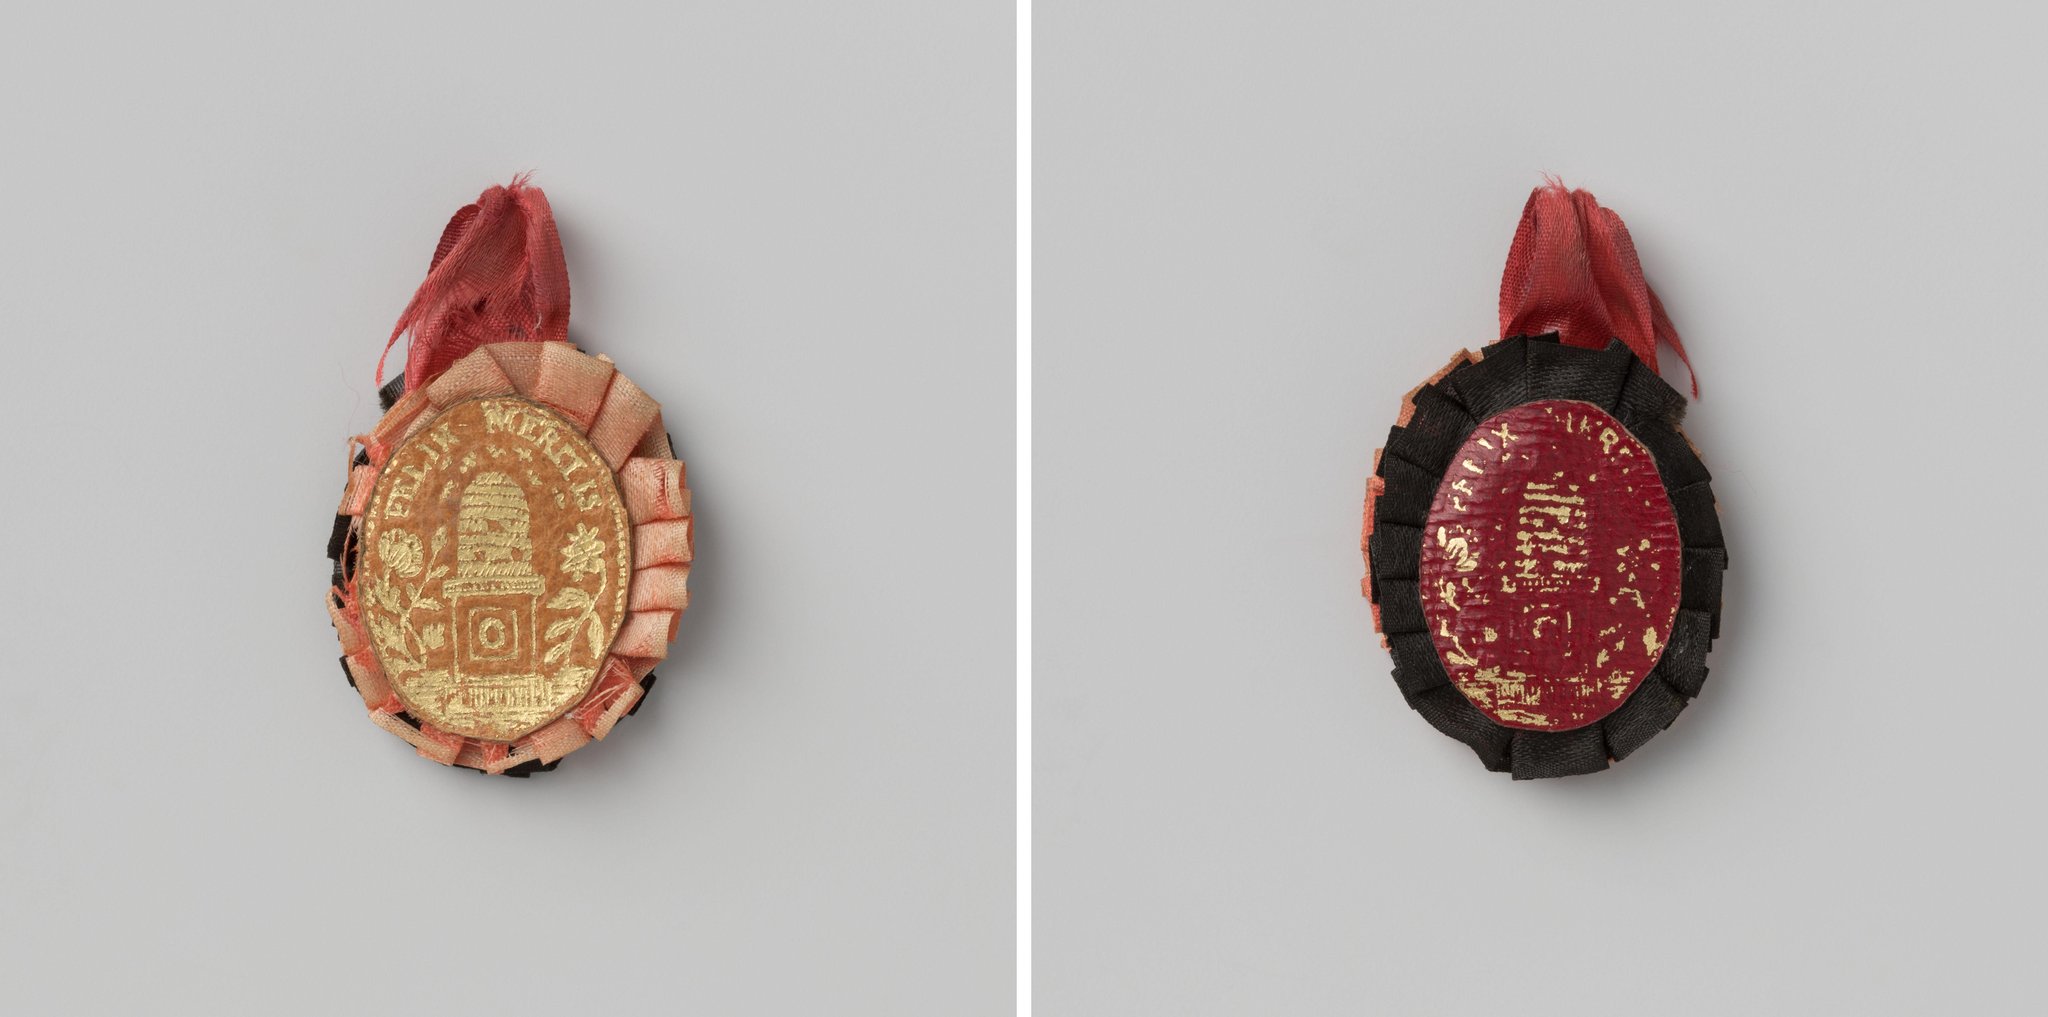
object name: insignia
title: Vereniging 'Felix Meritis' te Amsterdam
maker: Anonymous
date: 1777-1880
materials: leather, textile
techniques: printing, sewing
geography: amsterdam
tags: amsterdam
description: Ovaal insigne, bestaande uit drager aan rood lint, waarop aan voorzijde is aangebracht rozet van rood geplooid textiel en lichtrood, lederen plaatje met in goud: bijenkorf staande op altaar tussen twee bloemen binnen omschrift, en aan keerzijde rozet van zwart geplooid textiel en donkerrood, lederen plaatje met in goud: bijenkorf staande op altaar tussen twee bloemen binnen omschrift.